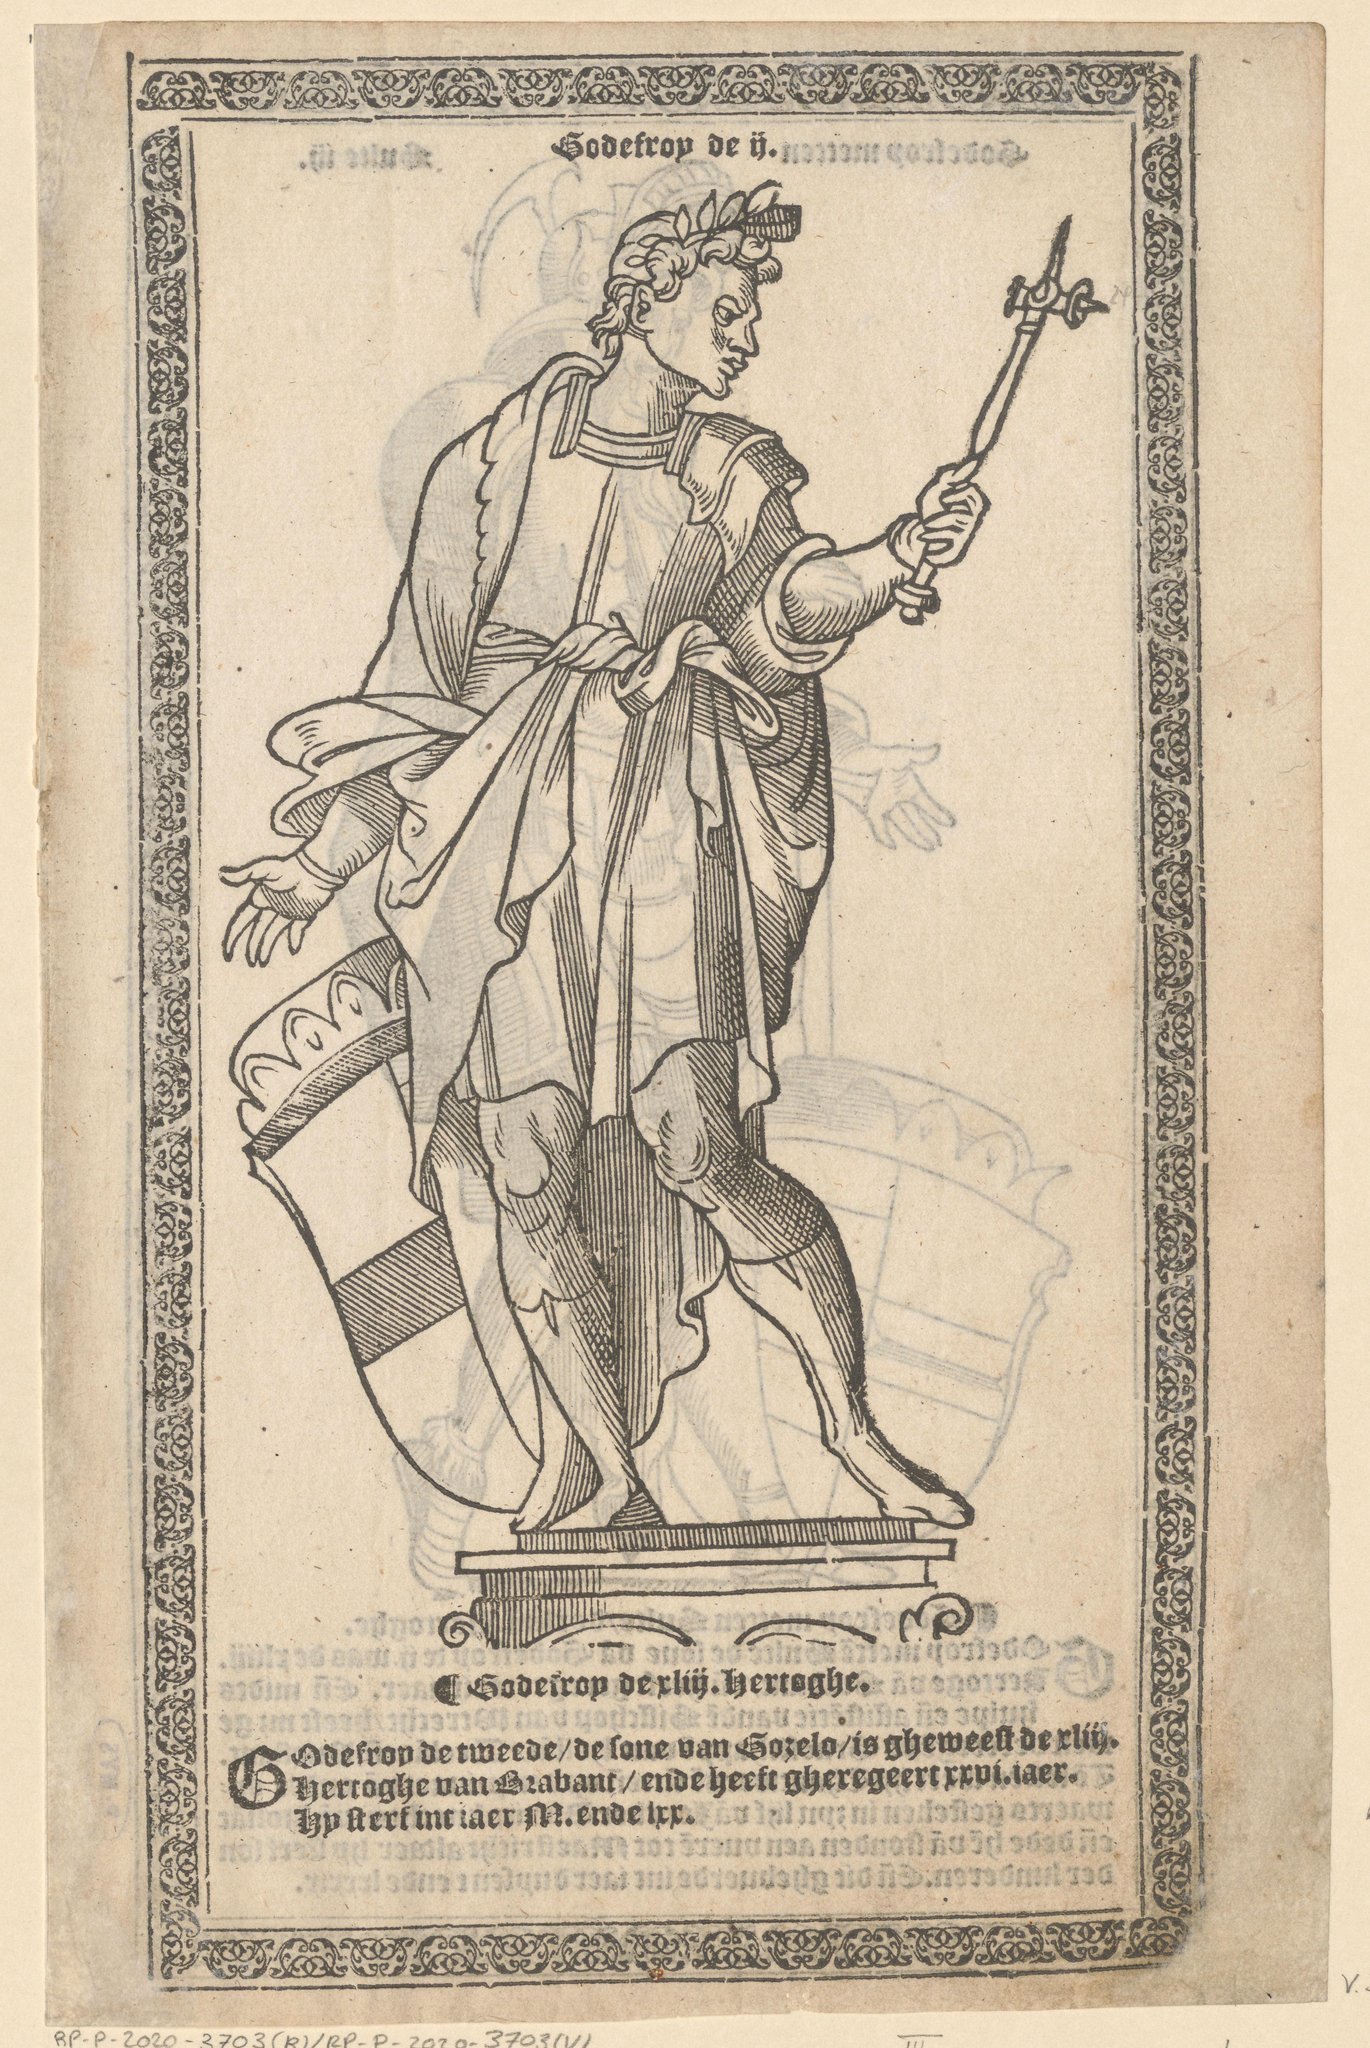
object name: print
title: Portret van Godfried II, hertog van Lotharingen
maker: jan molijns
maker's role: print maker, publisher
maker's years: 1498-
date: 1565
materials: paper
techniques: letterpress printing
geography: antwerp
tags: historical persons, armorial bearing, heraldry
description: Prent uit: Dit is die afcoemste ende genalogie der hertoghen ende hertoginnen van Brabandt, (...). Antwerpen: Jan Molijns, 1565.